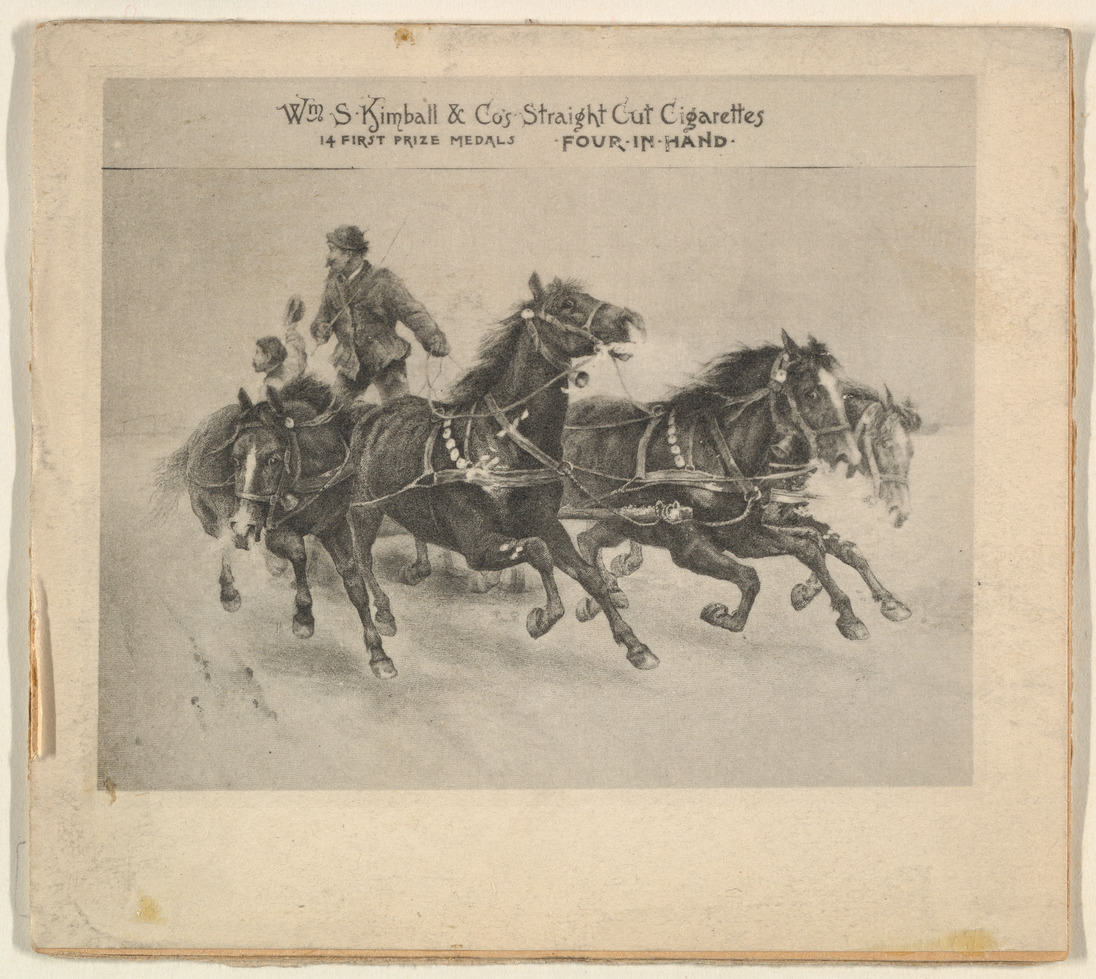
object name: print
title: Four in Hand, from the Sports and Art Subjects series (N197) issued by Wm. S. Kimball & Co.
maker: william s. kimball & company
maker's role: publisher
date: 1889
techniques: color lithograph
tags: men,horses